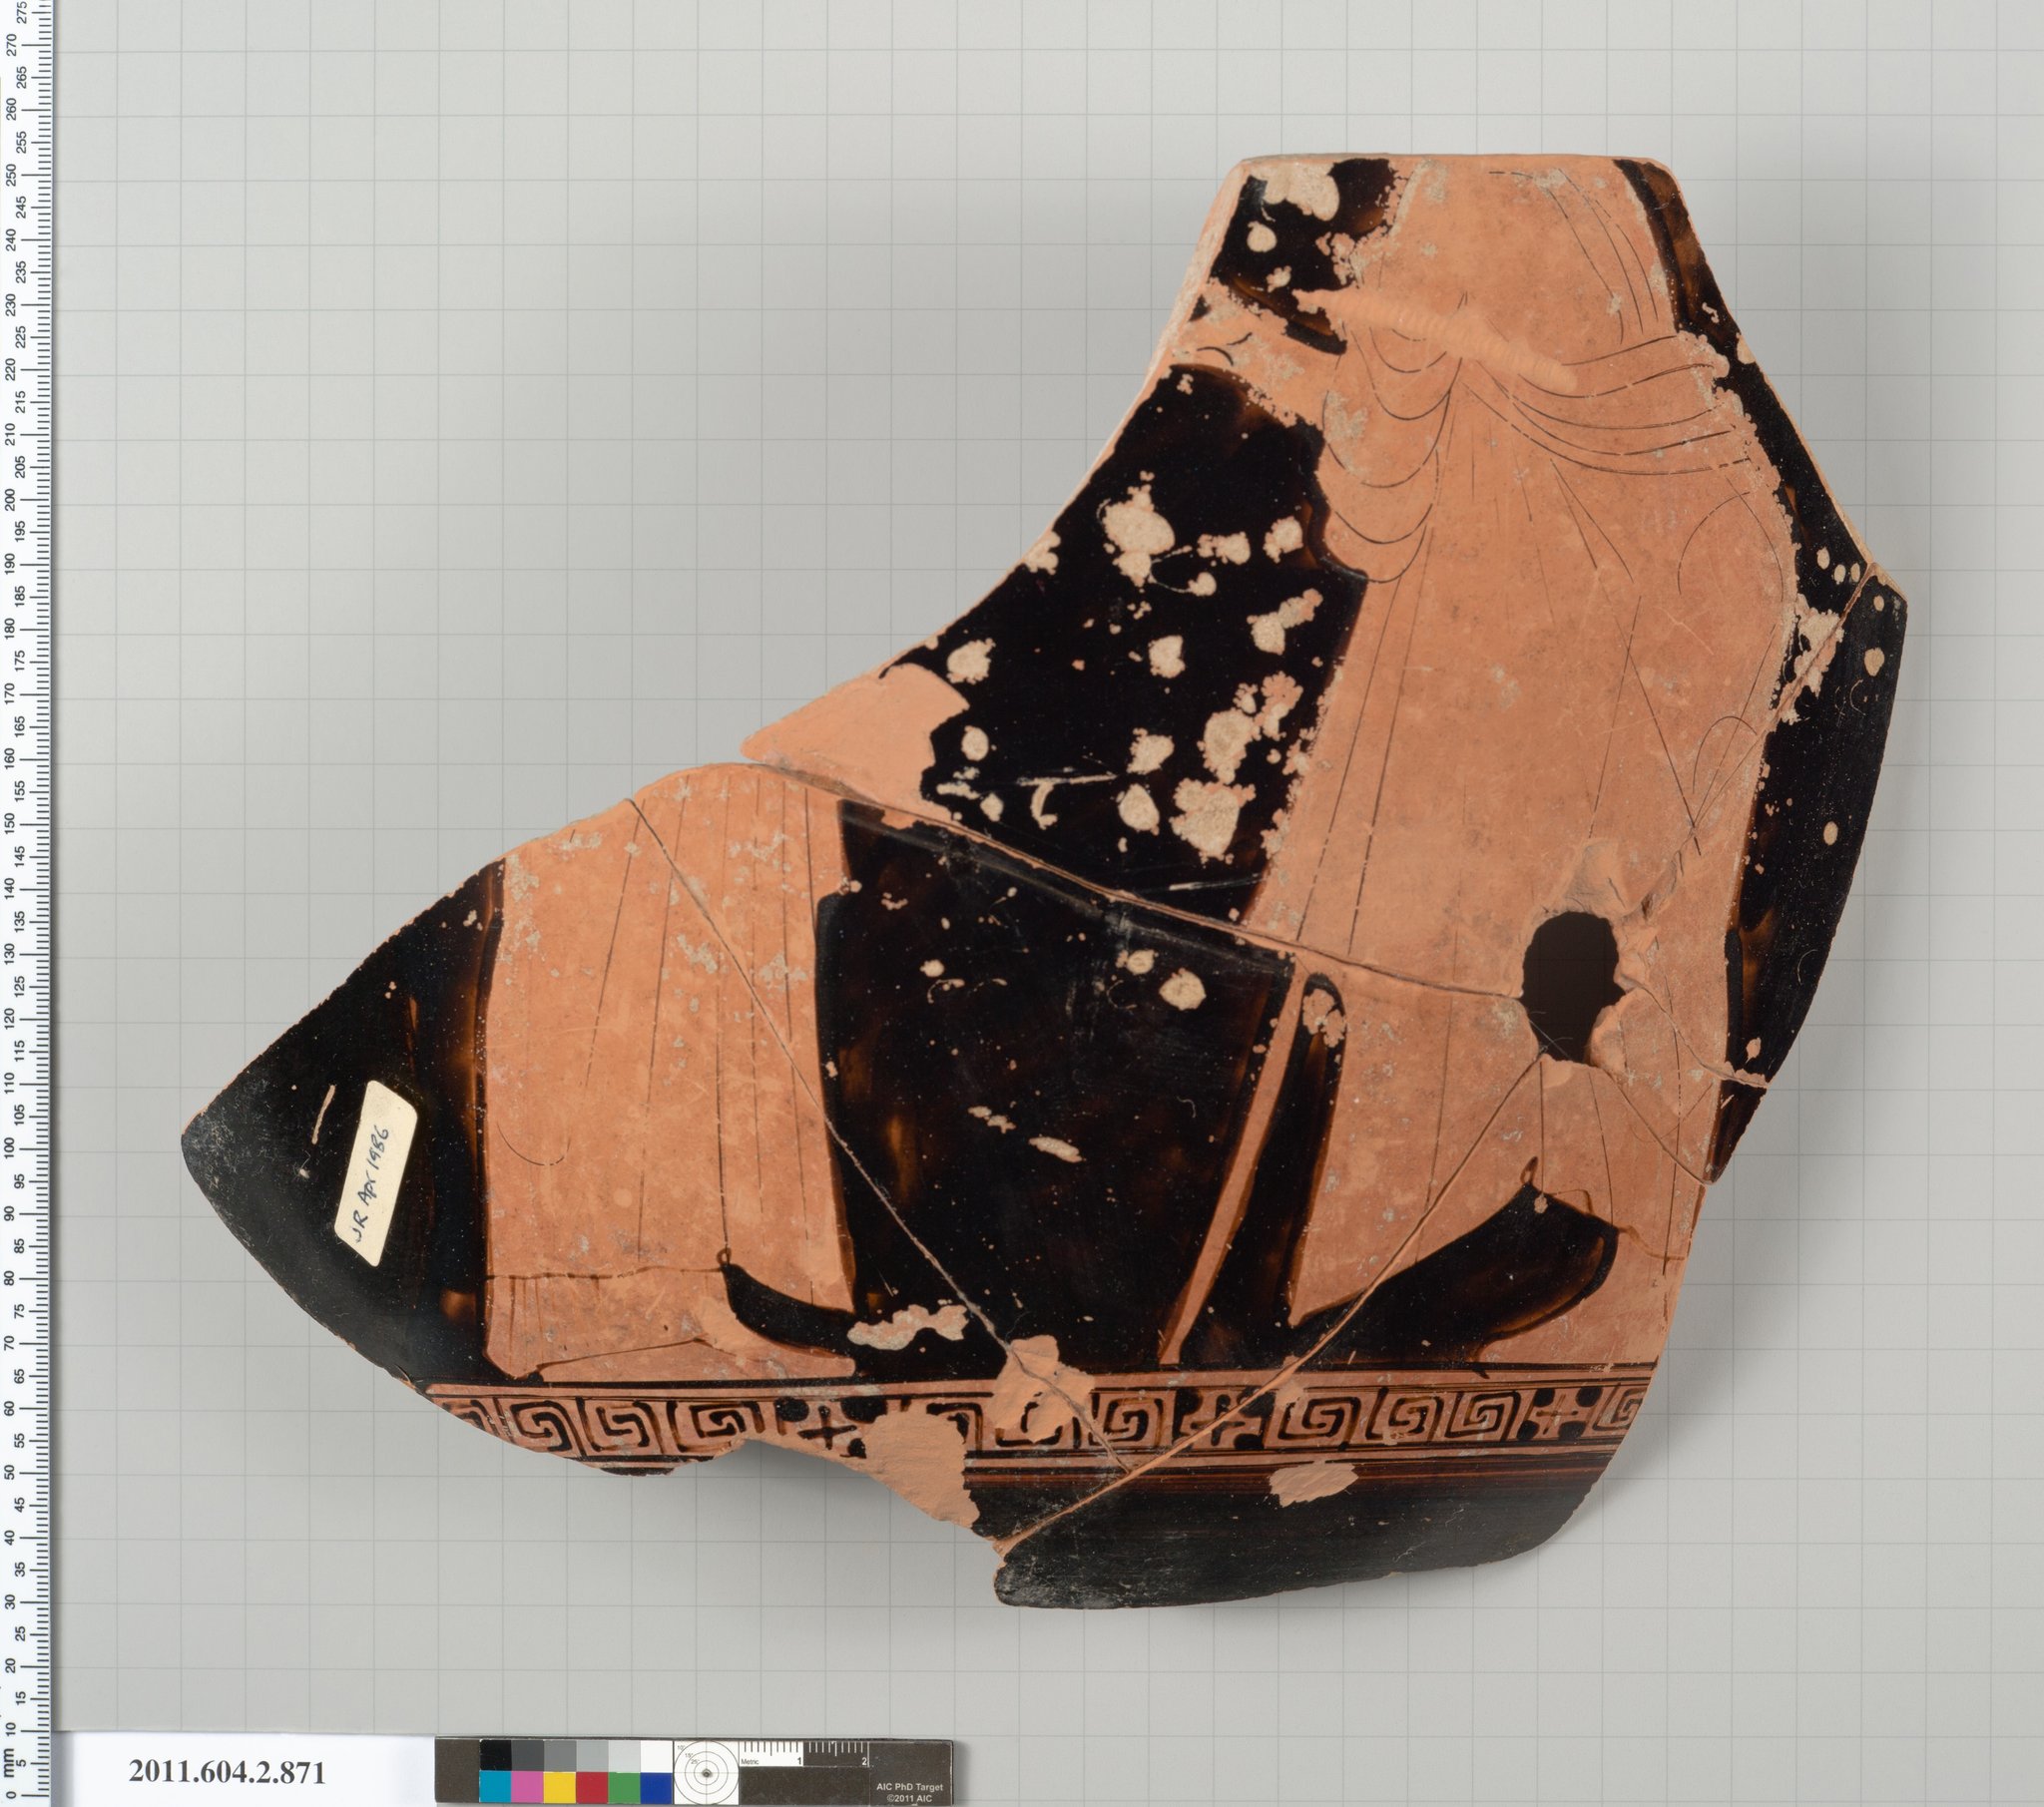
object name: bell krater fragment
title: Terracotta fragment of a bell-krater (bowl for mixing wine and water)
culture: greek, attic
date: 450-440 BCE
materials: terracotta